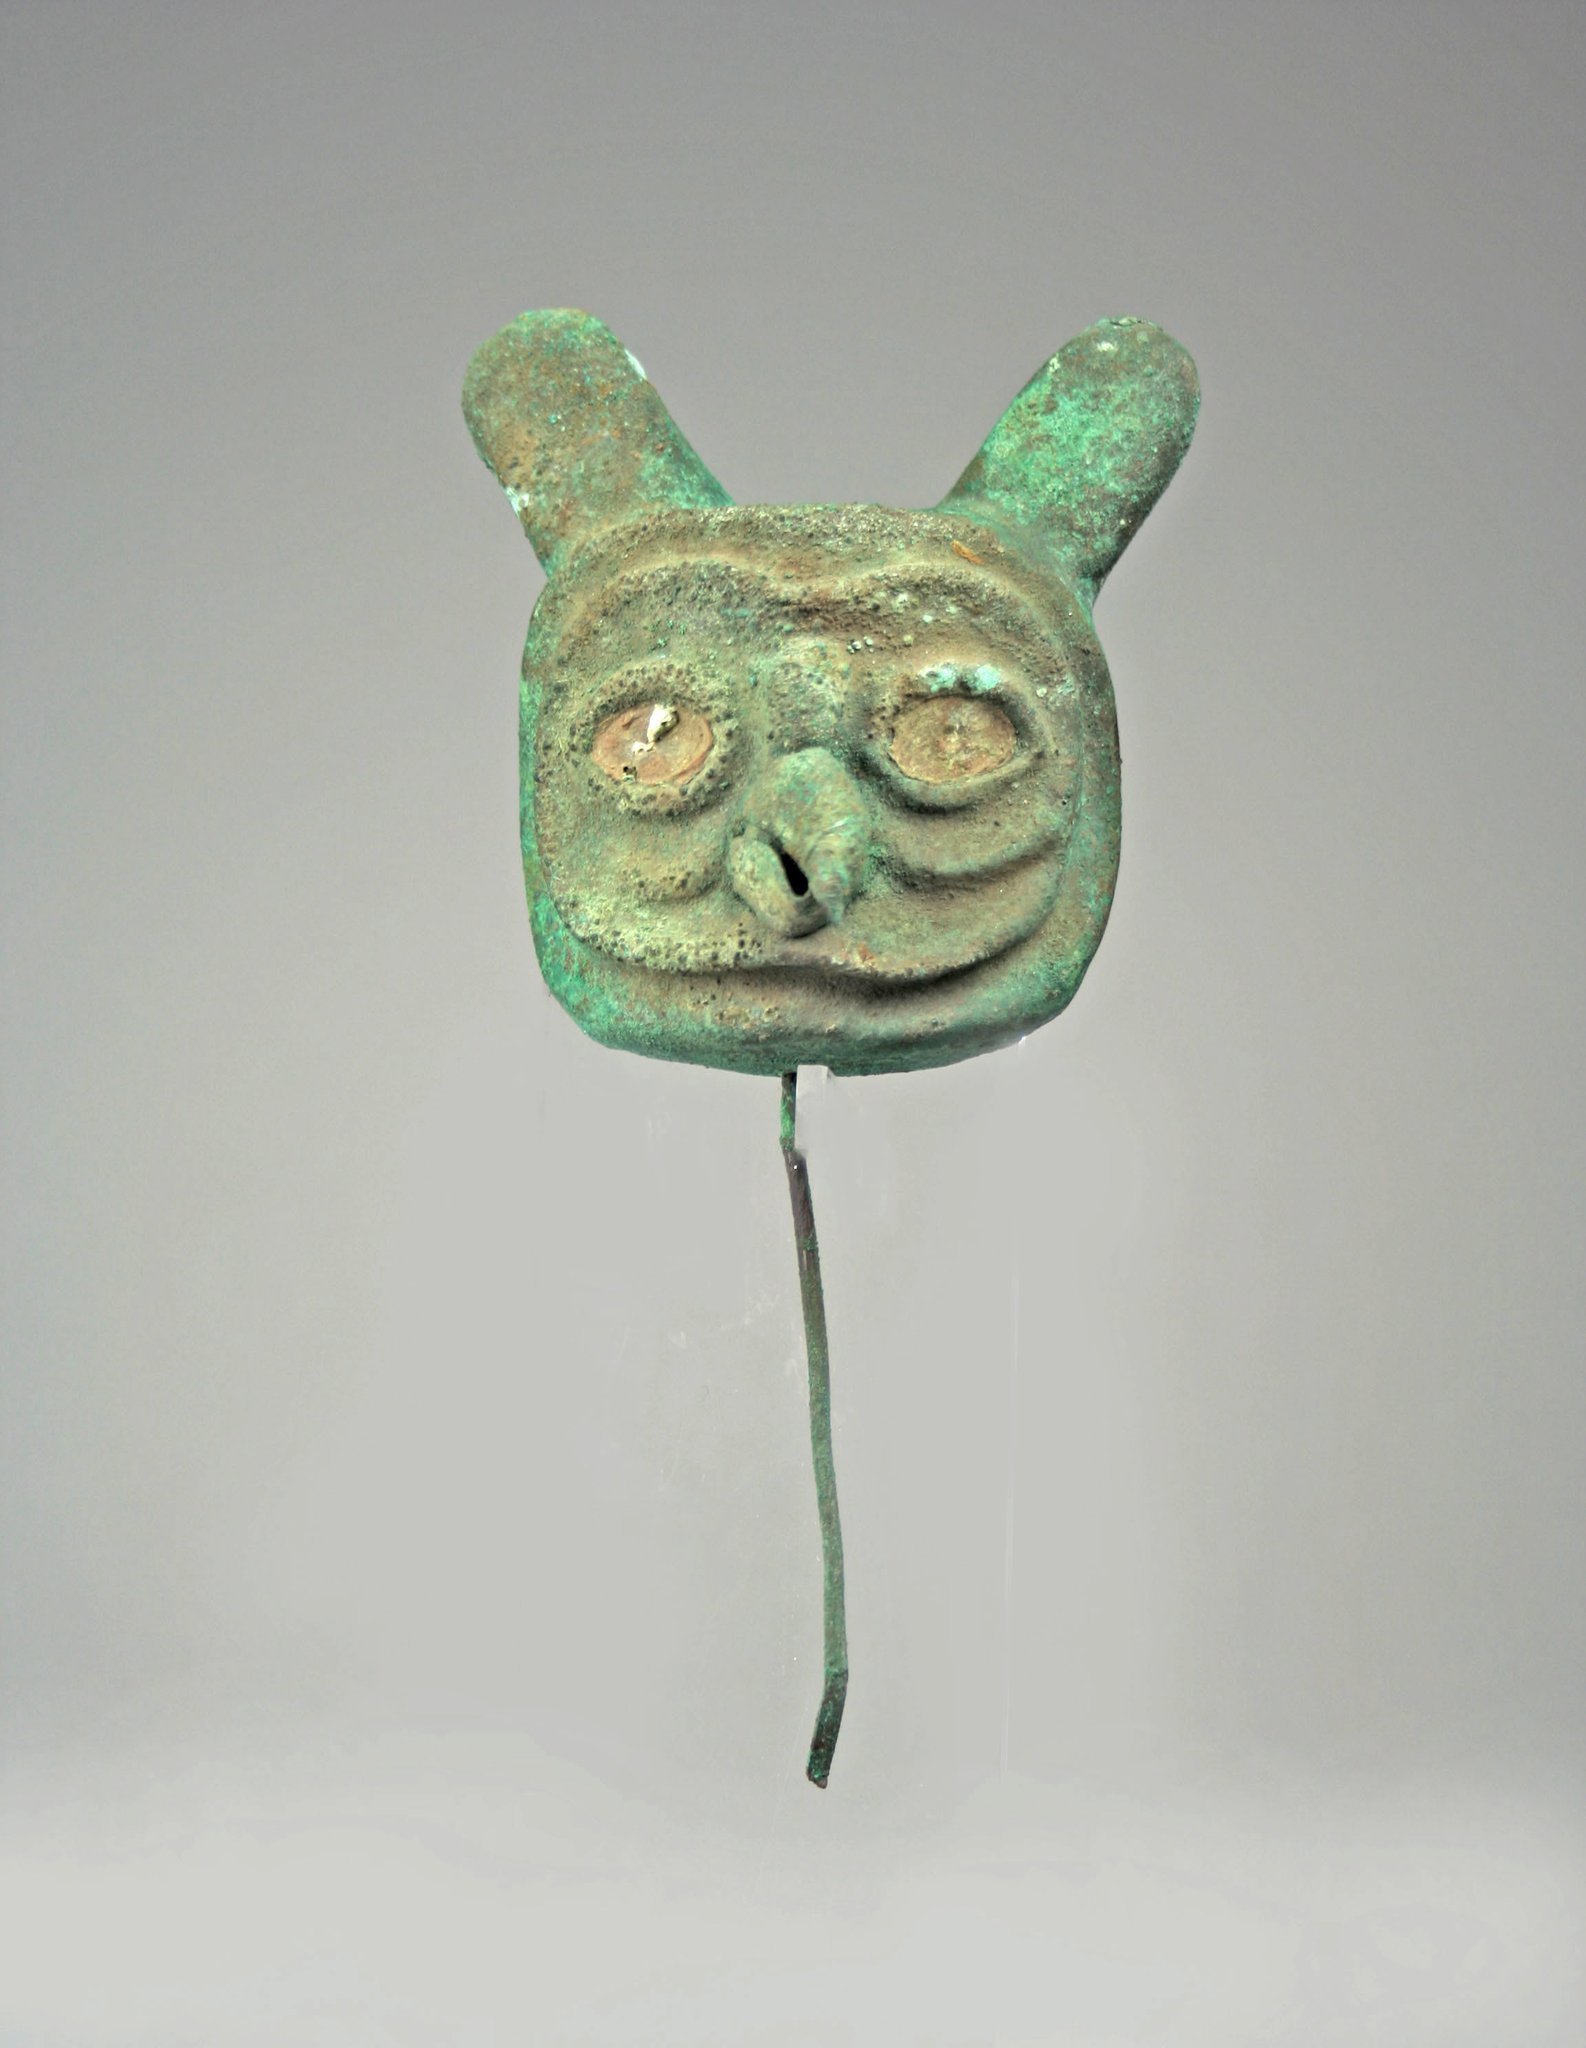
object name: ornament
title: Owl Head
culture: moche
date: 501-700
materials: gilt copper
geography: peru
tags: owls